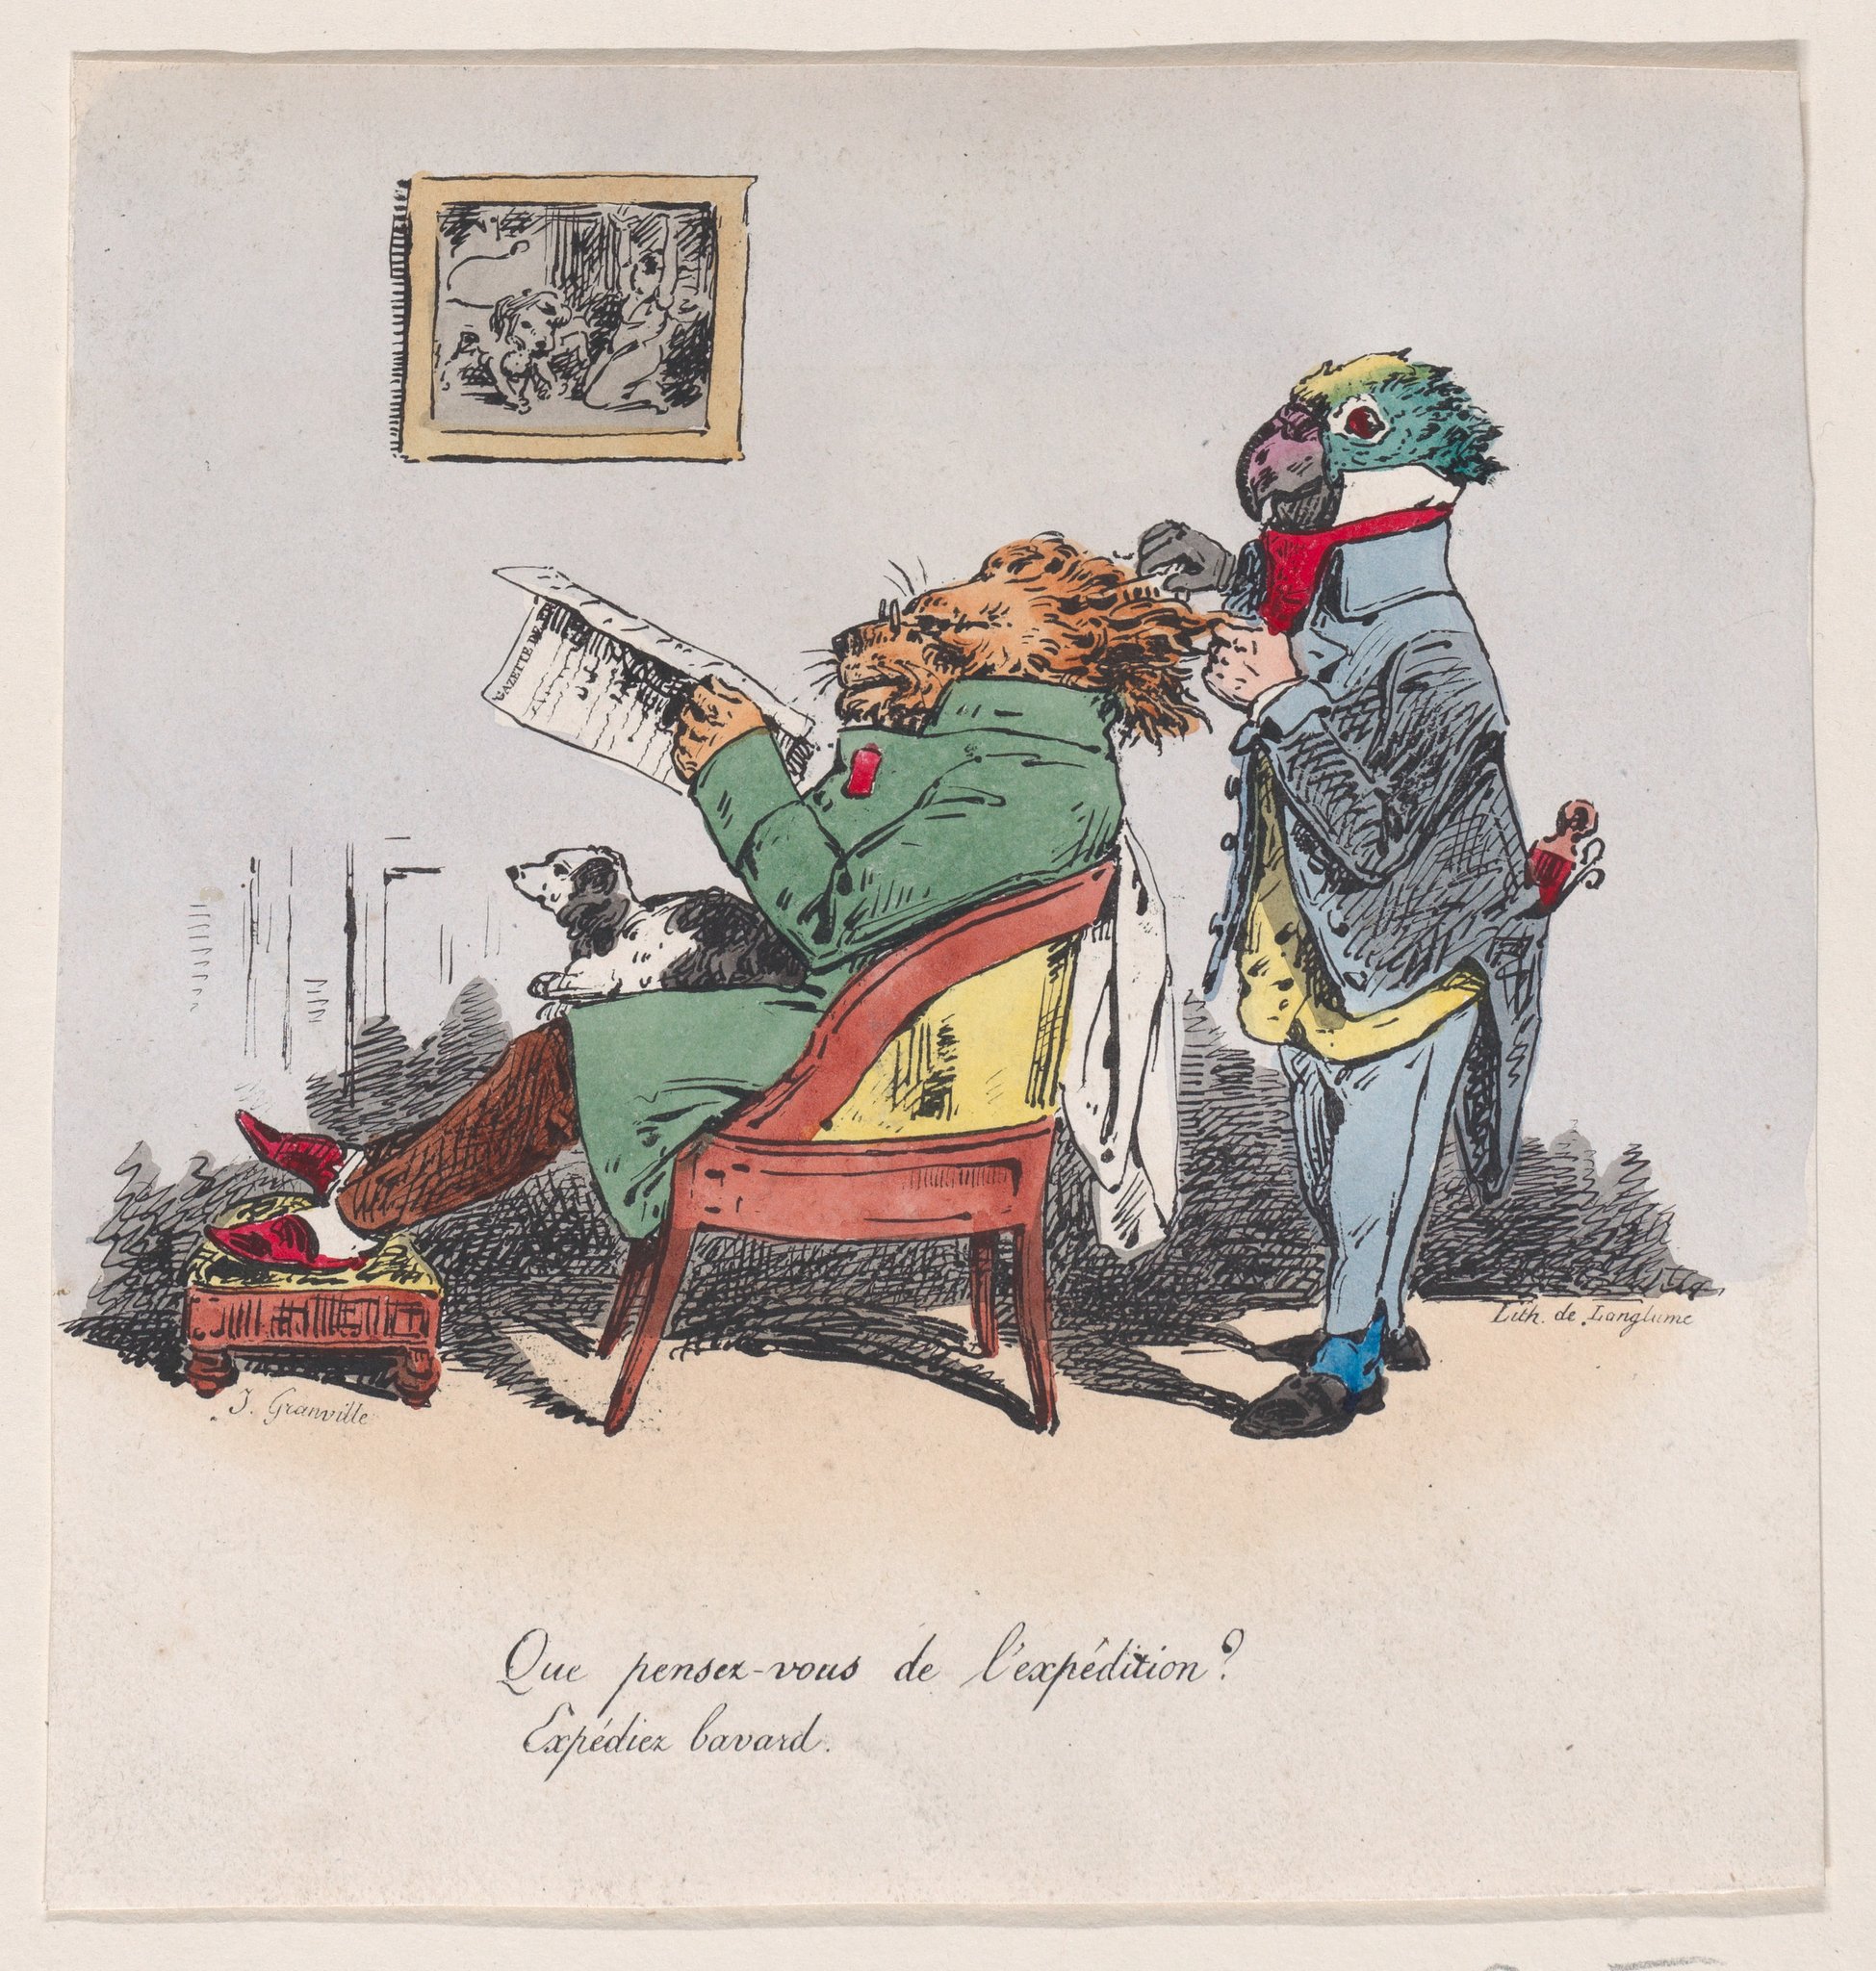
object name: print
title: What do you think of the expedition?, from "Metamorphoses of the Day"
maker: j. j. grandville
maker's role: designer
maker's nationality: french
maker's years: 1803-1847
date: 1829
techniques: hand coloring, lithograph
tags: birds,satire,dogs,lions